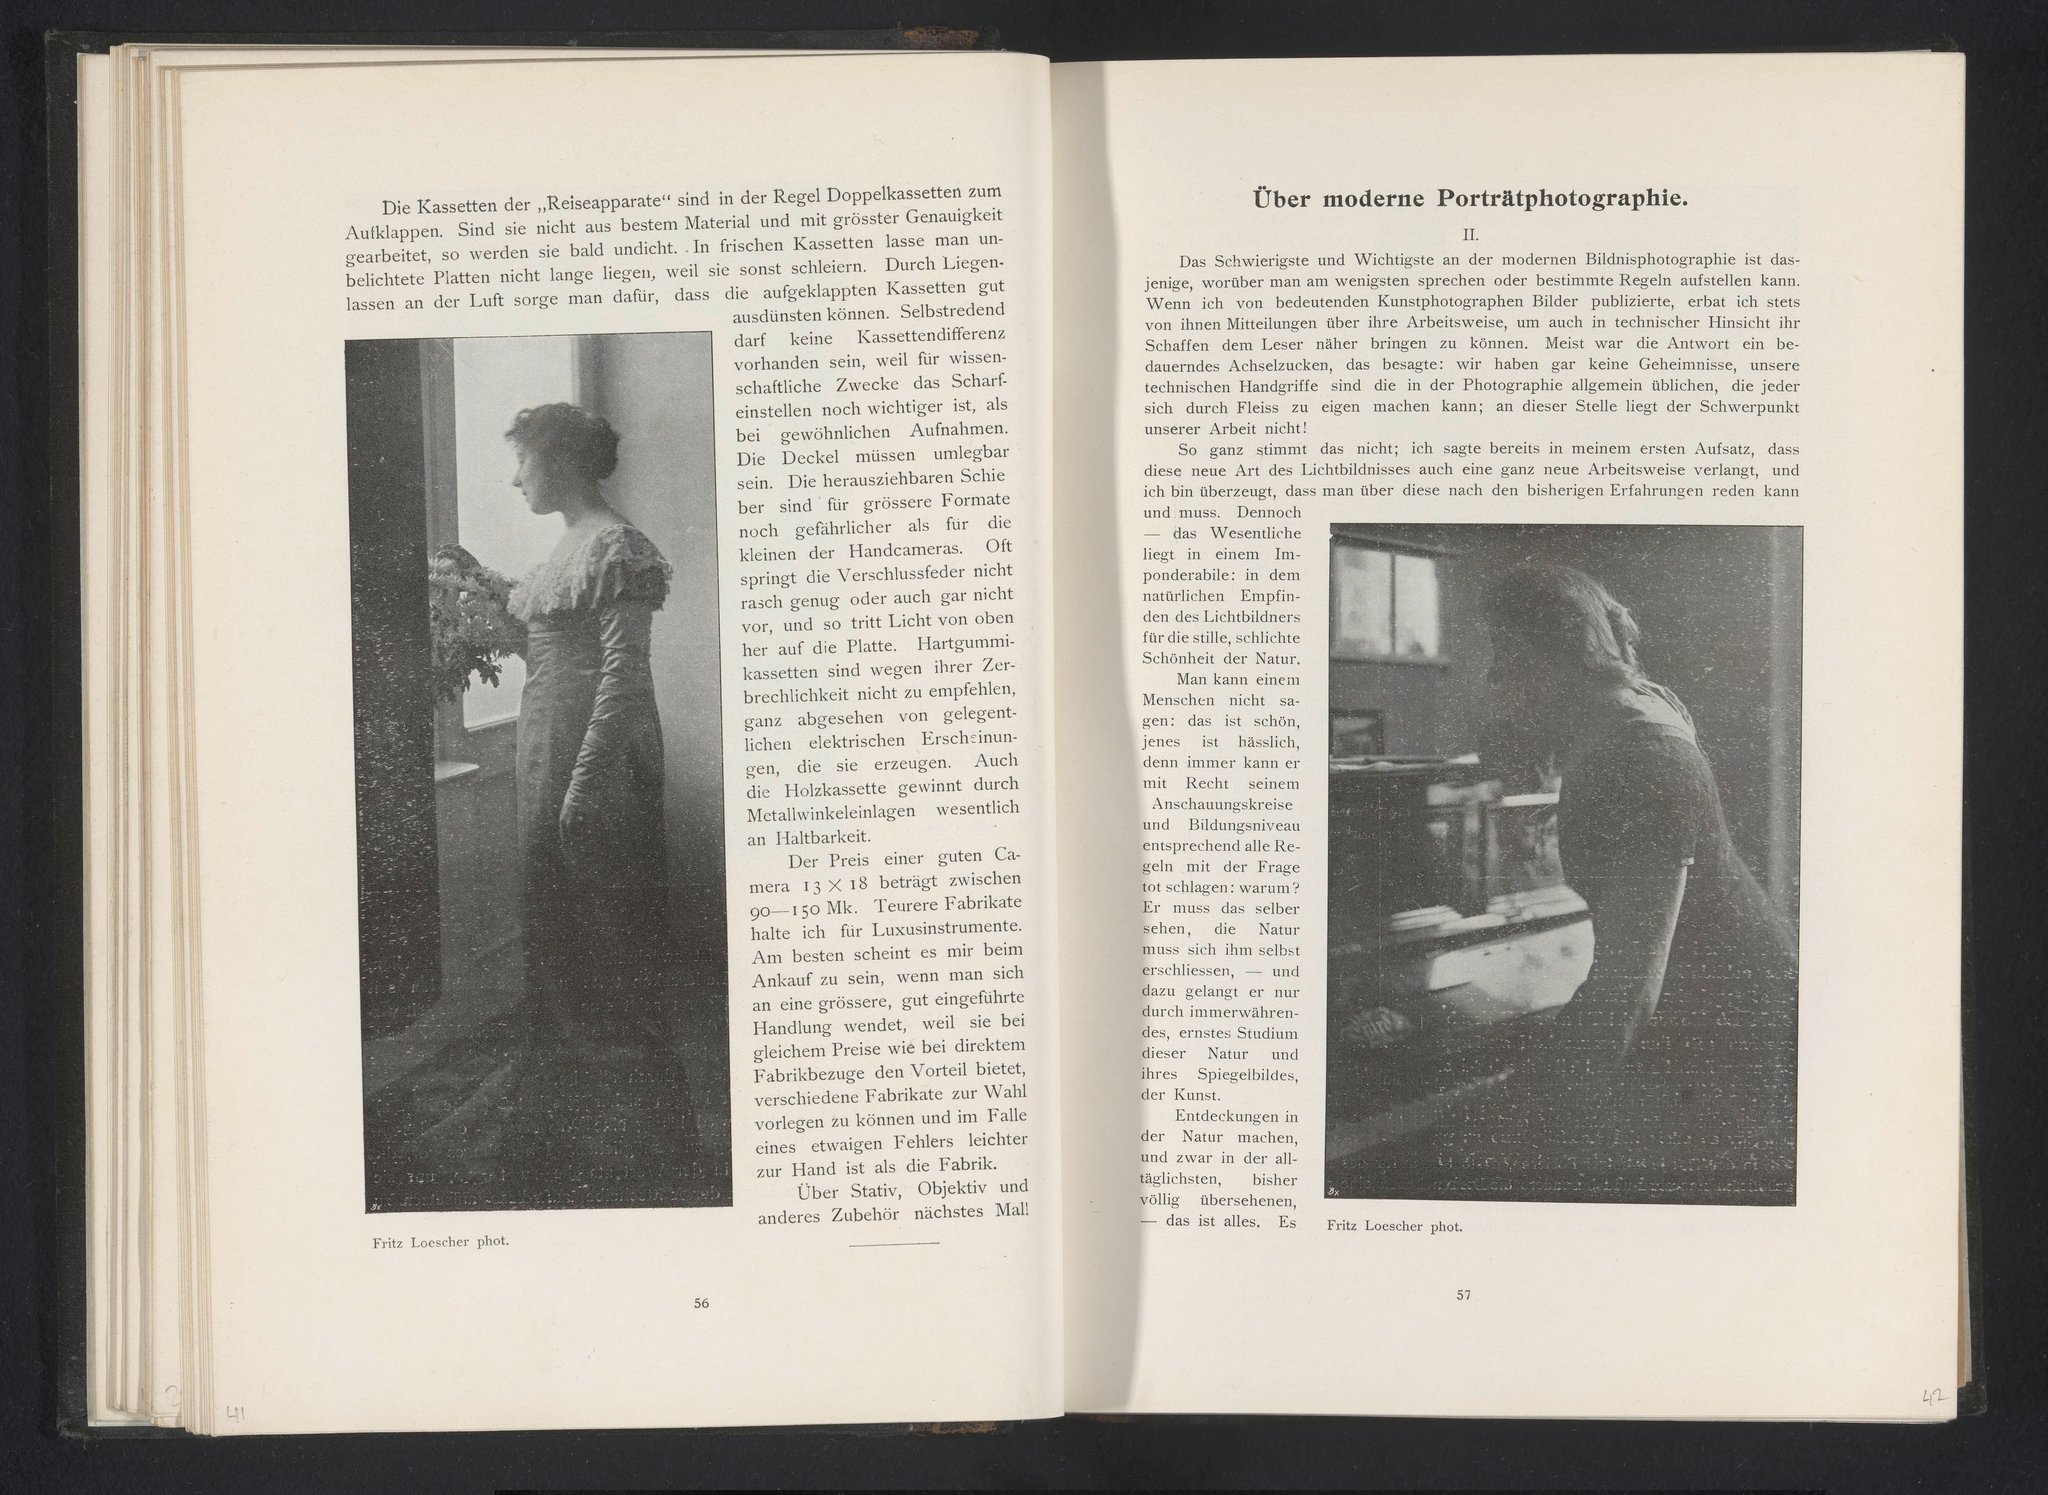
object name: photomechanical print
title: Portret van een onbekende vrouw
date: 1898-1903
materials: paper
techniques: autotype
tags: historical persons - bb - woman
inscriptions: monogram: ‘BX’